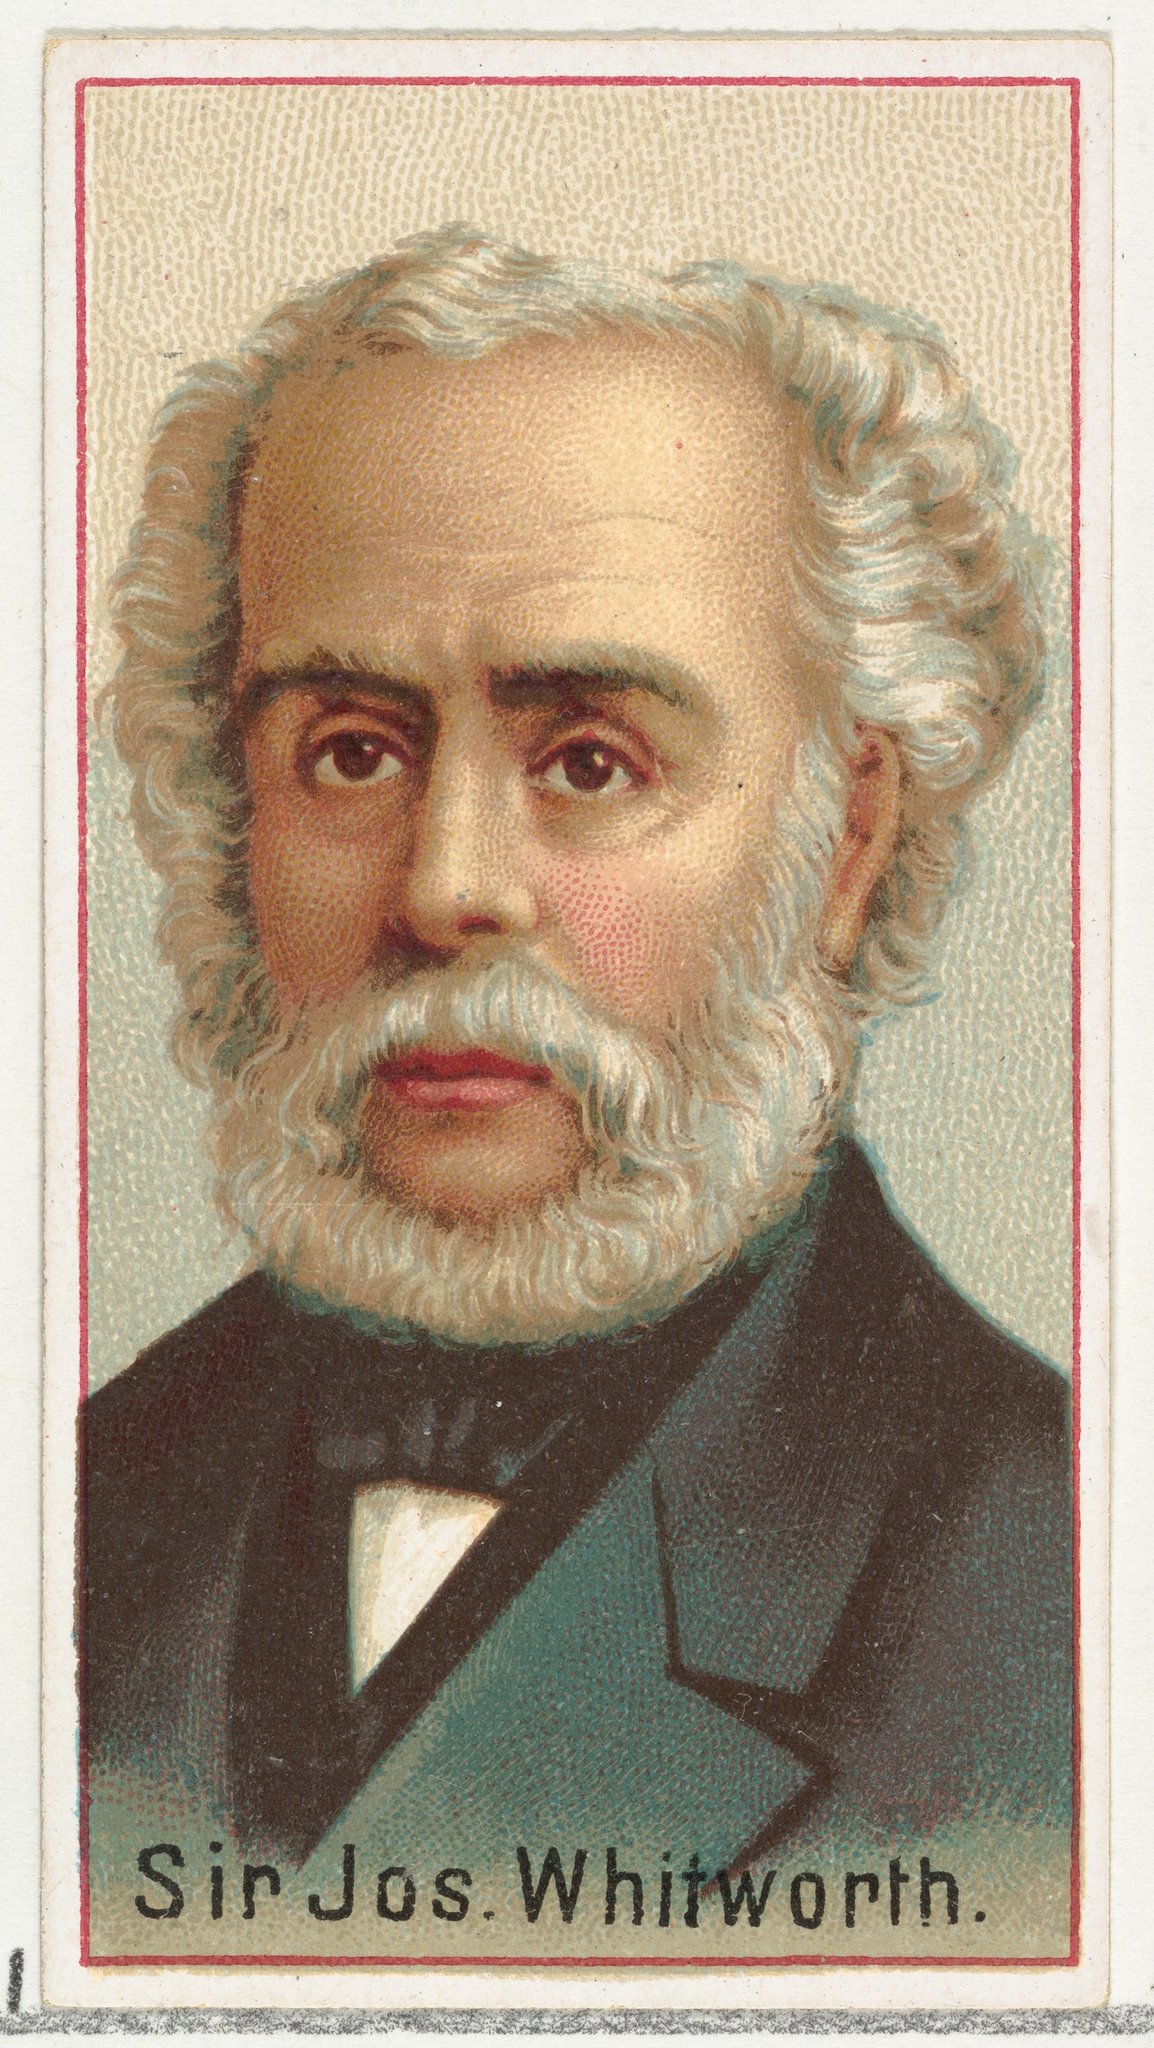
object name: print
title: Sir Joseph Whitworth, printer's sample for the World's Inventors souvenir album (A25) for Allen & Ginter Cigarettes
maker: allen & ginter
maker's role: publisher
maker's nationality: american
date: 1888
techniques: color lithograph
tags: men,portraits